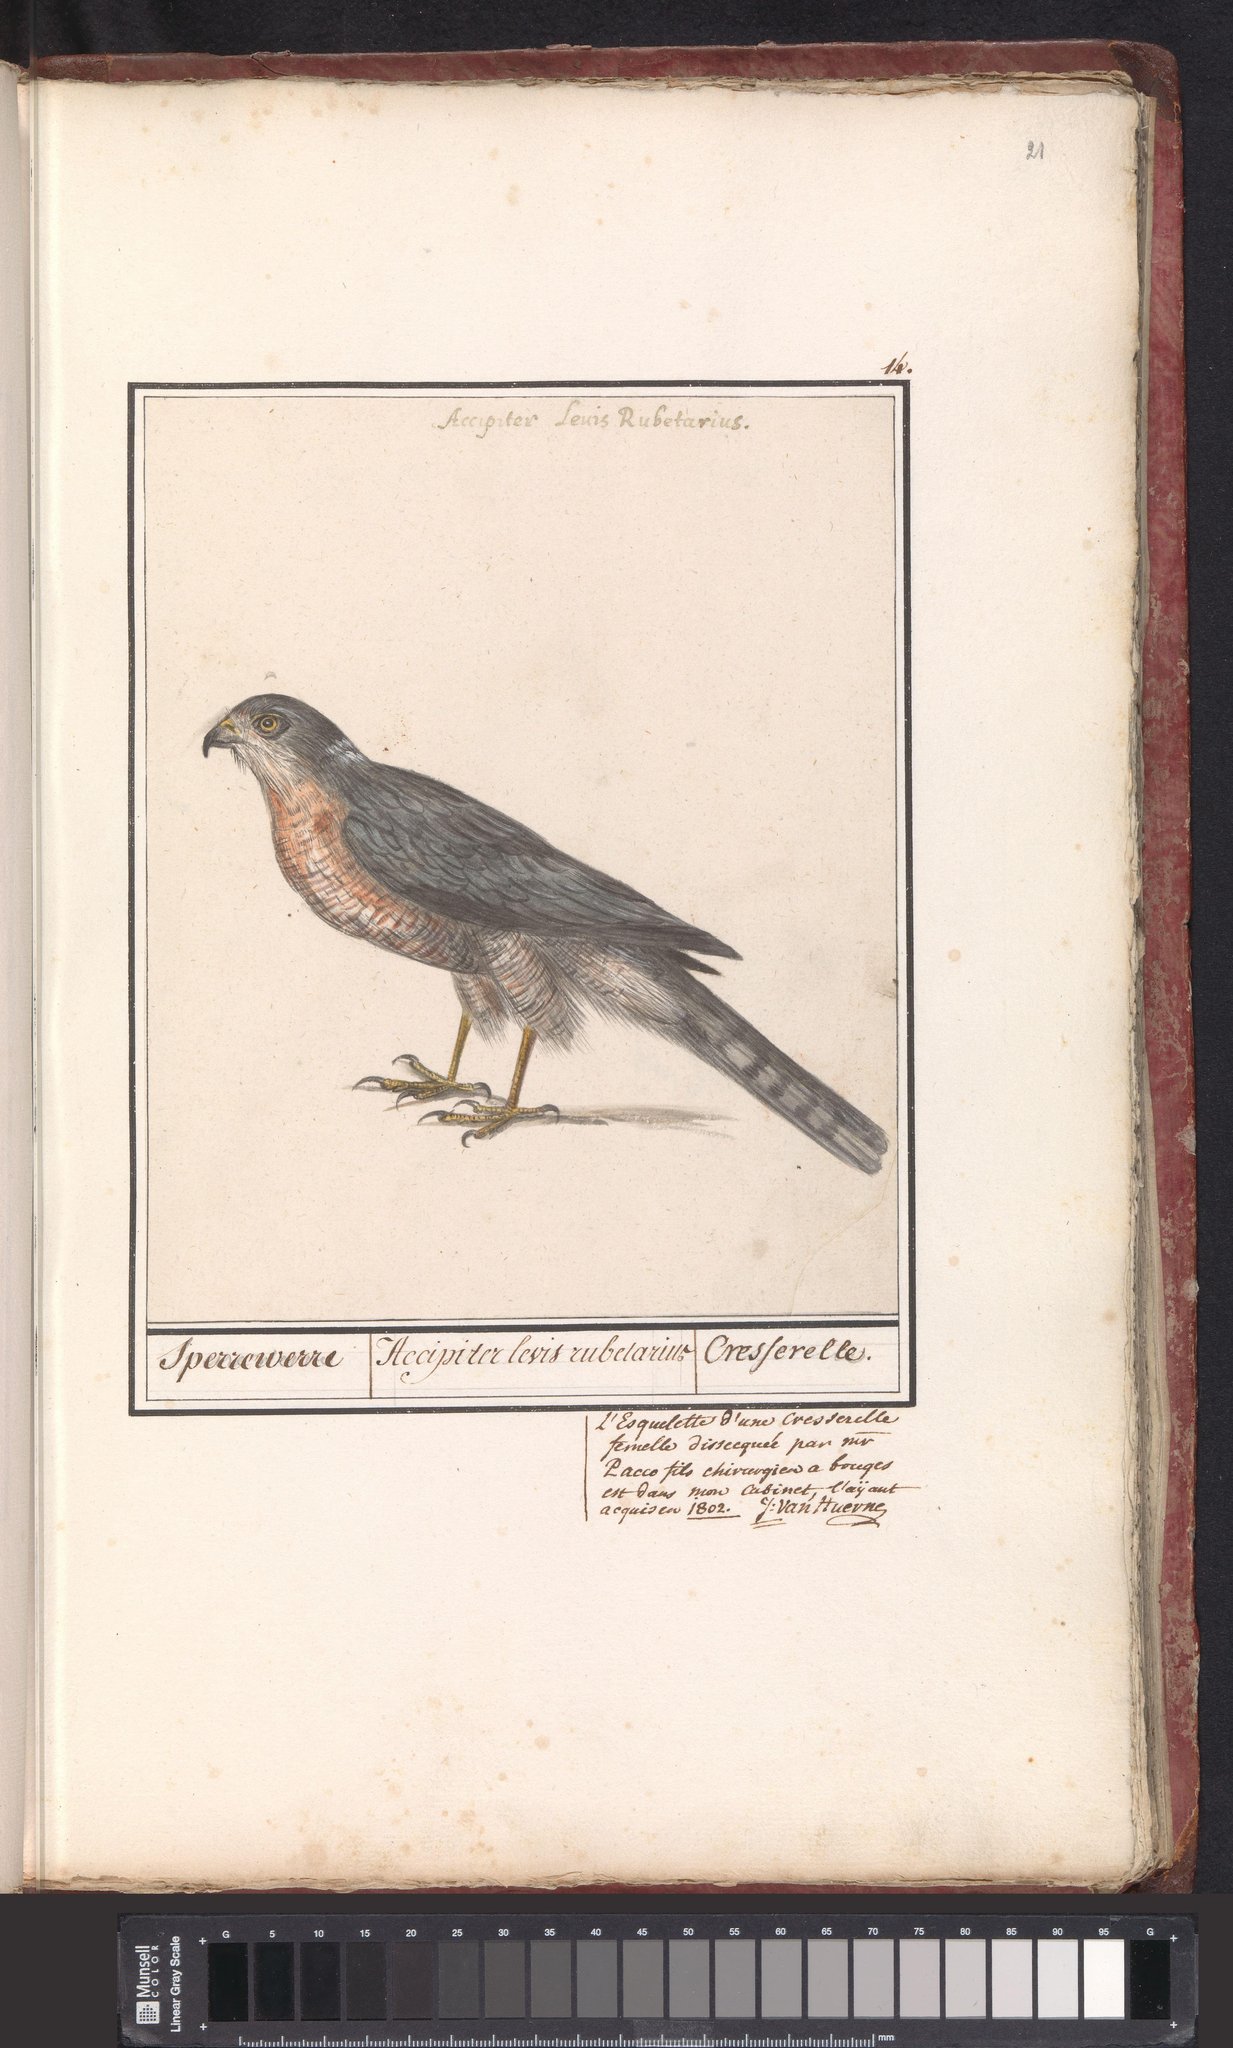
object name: drawing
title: Sperwer (Accipiter nisus)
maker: joseph van huerne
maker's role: kunstliefhebber, mecenas, verzamelaar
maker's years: 1752-1844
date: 1596-1610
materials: paint, ink, paper, pencil, watercolor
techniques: brush, pen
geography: bruges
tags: predatory birds: eurasian sparrowhawk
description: Sperwer. Genummerd rechtsboven: 14. Bovenaan de naam in het Latijn. Op het blad een annotatie van J.A. van Huerne uit of na 1802. Onderdeel van het eerste album met tekeningen van vogels. Derde van twaalf albums met tekeningen van dieren, vogels en planten bekend rond 1600, gemaakt in opdracht van keizer Rudolf II. Met toelichting in Nederlands, Latijn en Frans.